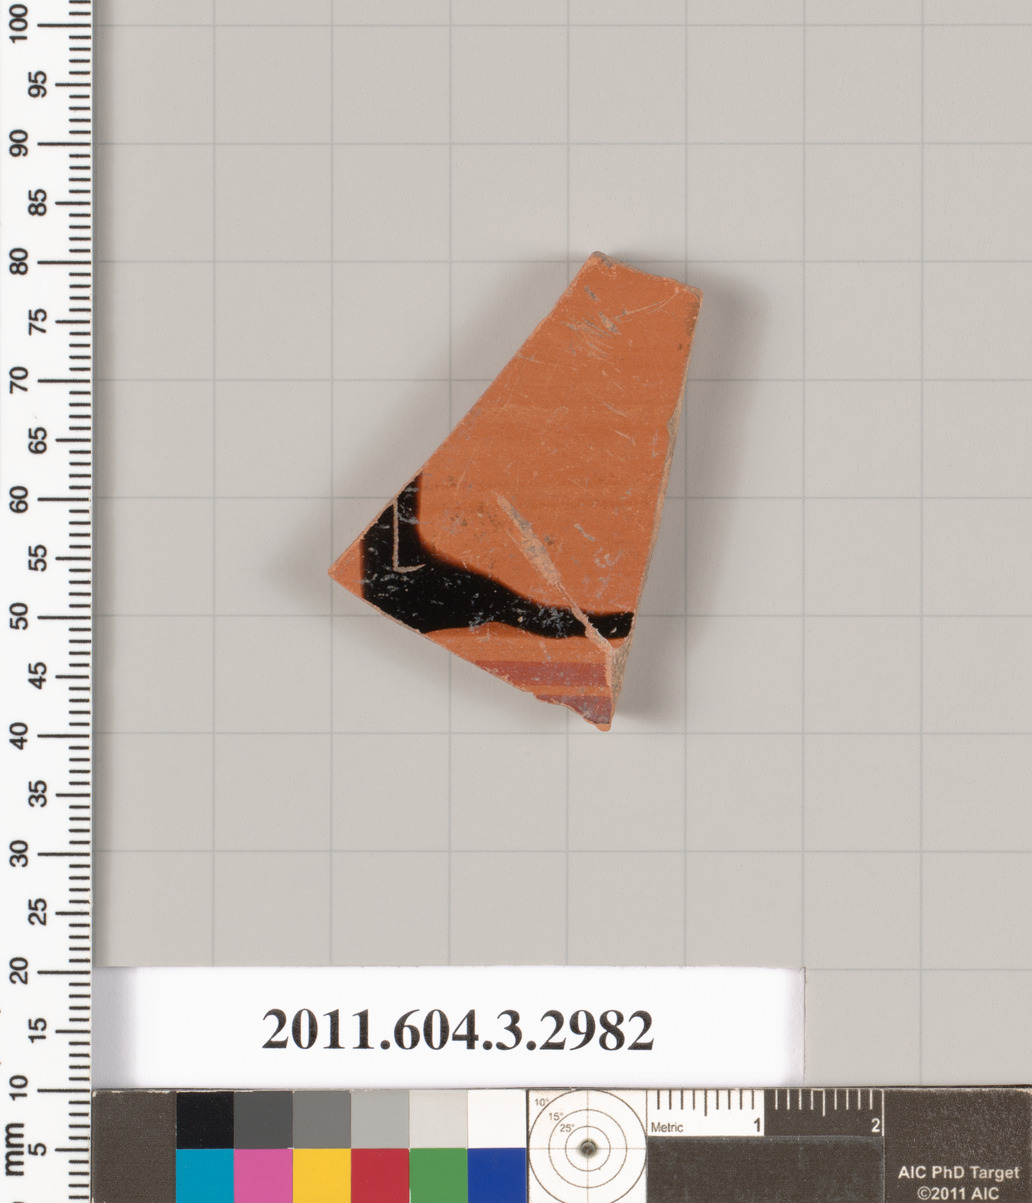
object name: amphora fragment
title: Terracotta fragment of an amphora (jar)?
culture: greek, attic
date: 534-468 BCE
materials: terracotta